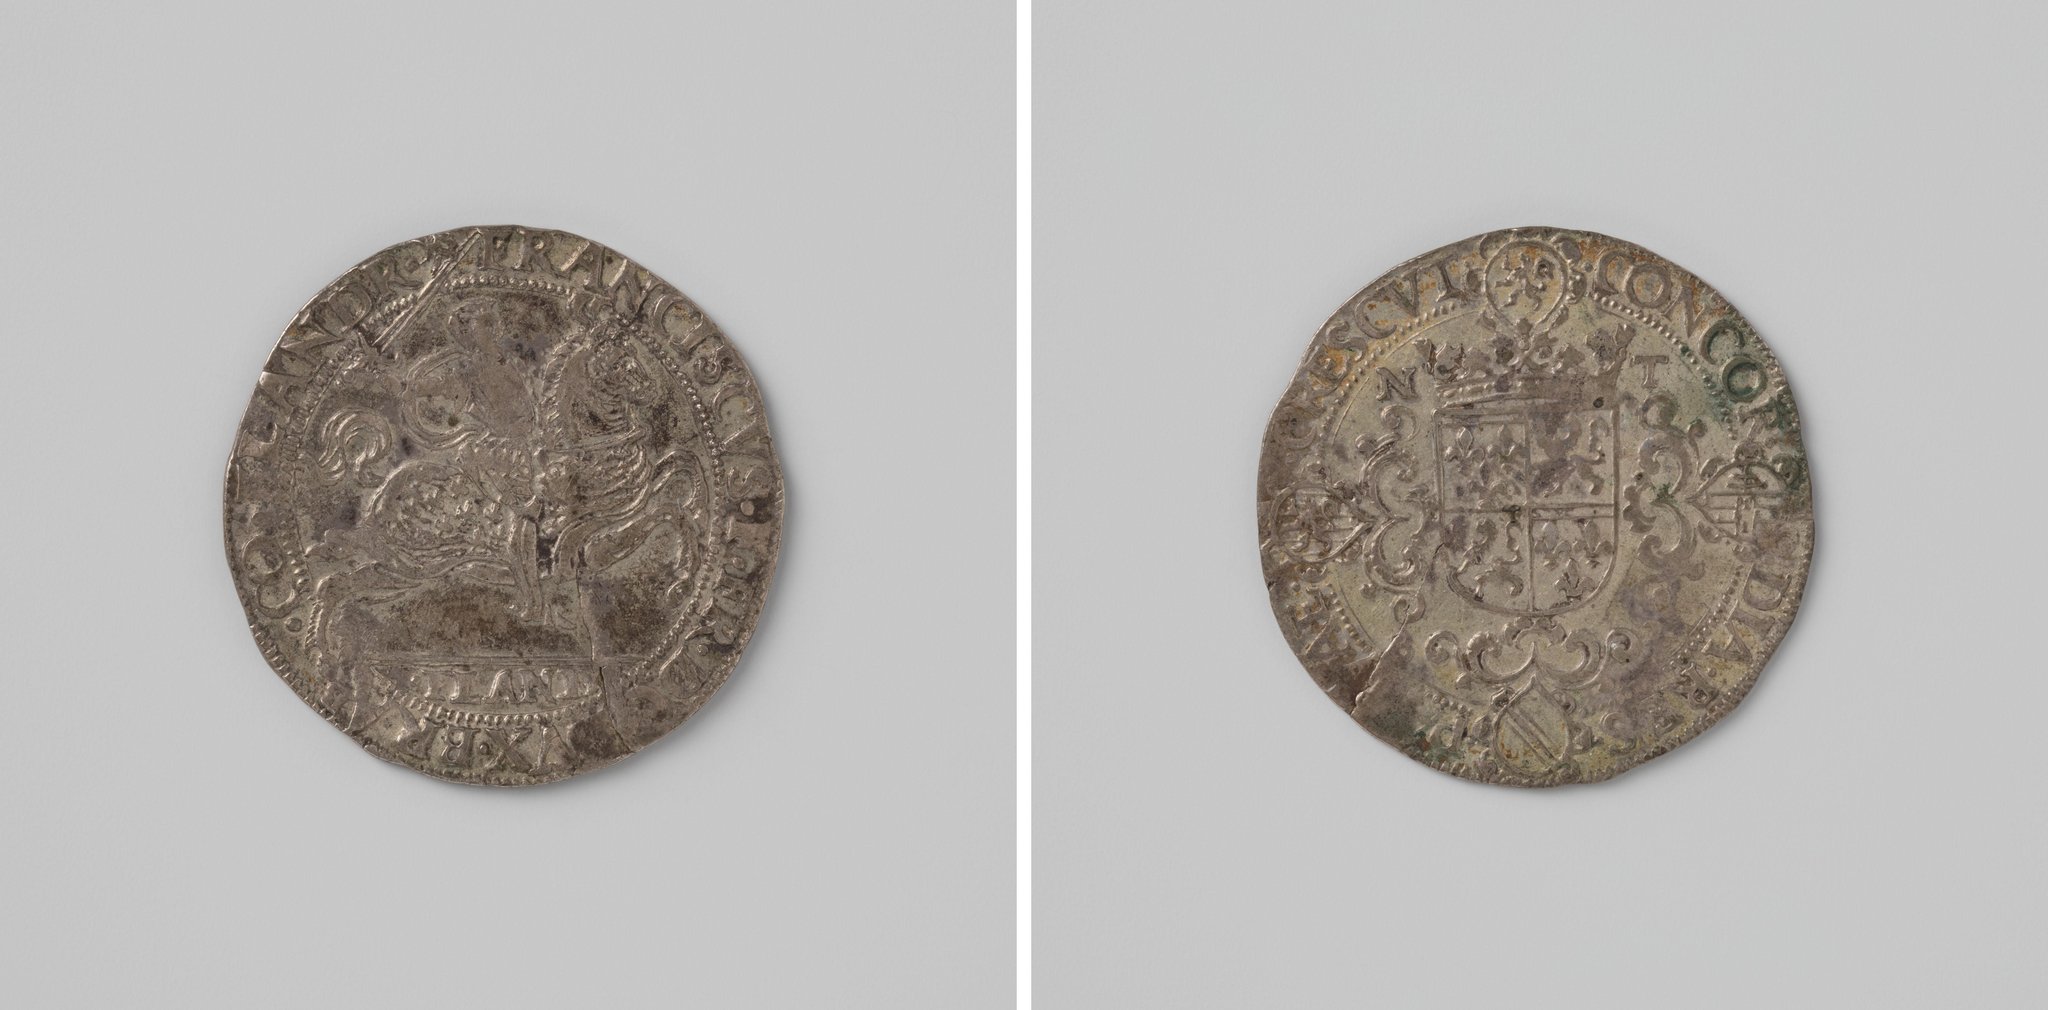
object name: history medal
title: Inhuldiging van de hertog van Anjou als hertog van Vlaanderen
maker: Anonymous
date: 1582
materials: silver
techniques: striking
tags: paris, françois-hercule de valois (hertog van anjou)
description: Zilveren penning. Voorzijde: ruiter met getrokken zwaard boven opschrift, binnen omschrift. Keerzijde: gekroond wapenschild binnen omschrift, onderbroken door vier wapenschilden